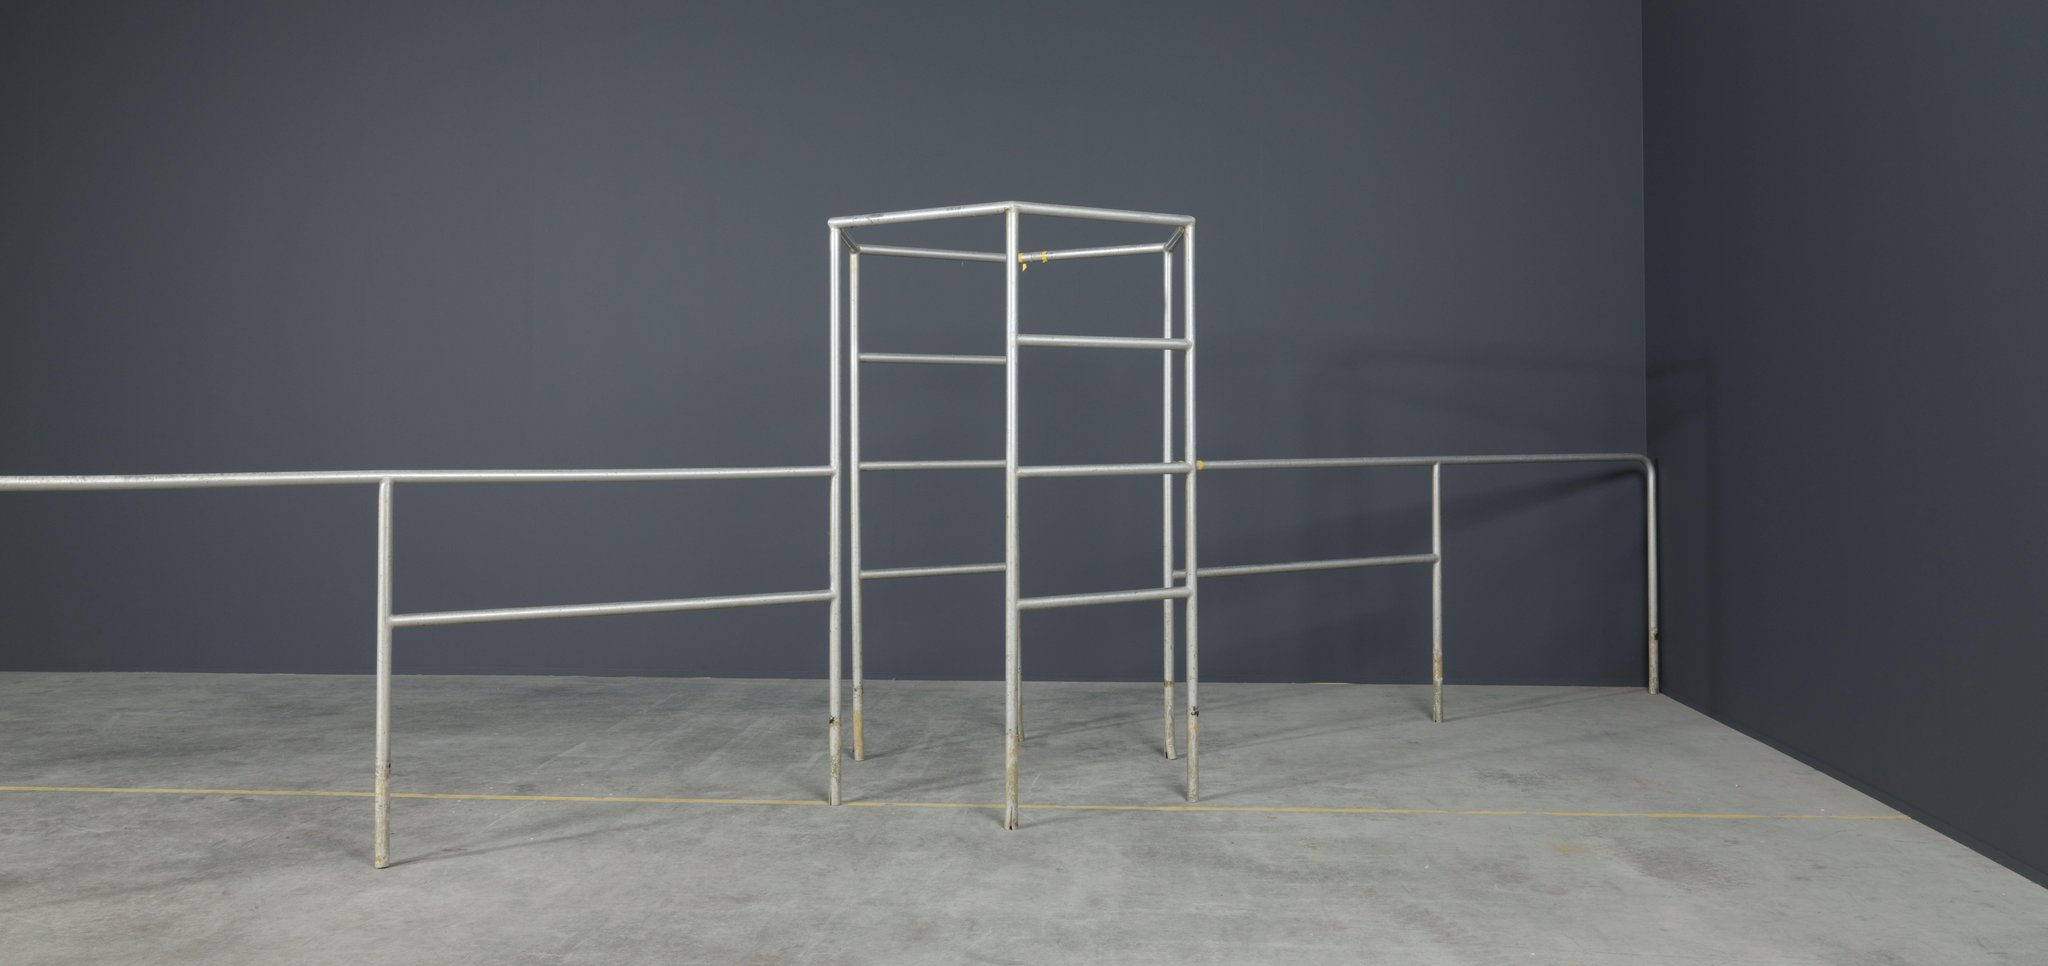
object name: speeltoestel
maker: aldo van eyck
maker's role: architect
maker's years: 1918-1999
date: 1962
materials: aluminum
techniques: welding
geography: netherlands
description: Aluminium buis, onderdeel van een speeltoestel.